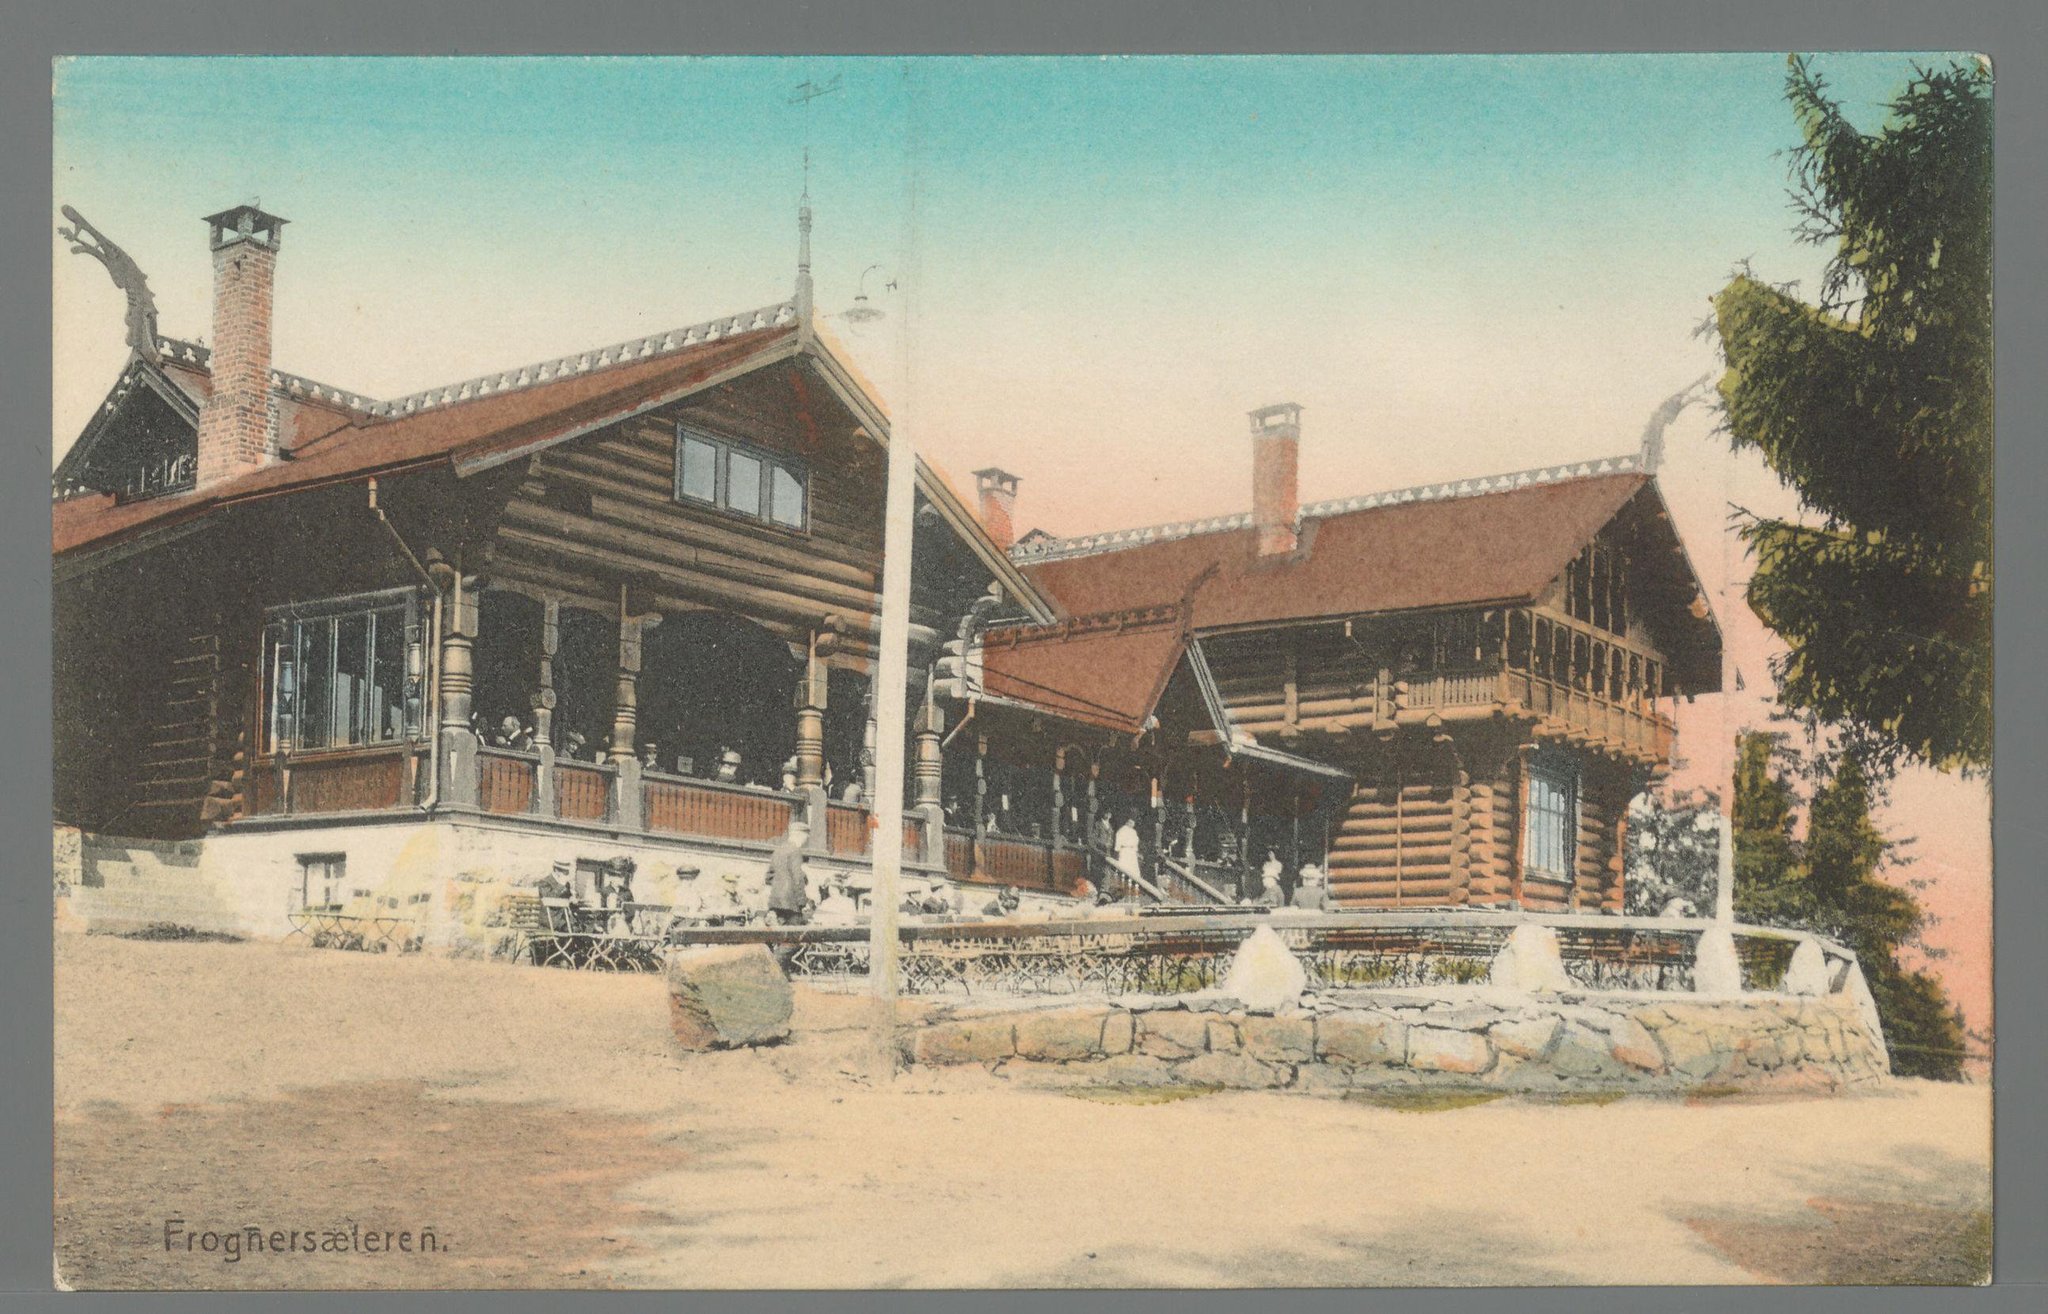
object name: ansichtkaart, prentbriefkaart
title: Frognersaeteren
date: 1906-1920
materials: cardboard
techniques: photograph, lithograph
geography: frognerseteren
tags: loggia, verandah, porch, country-house